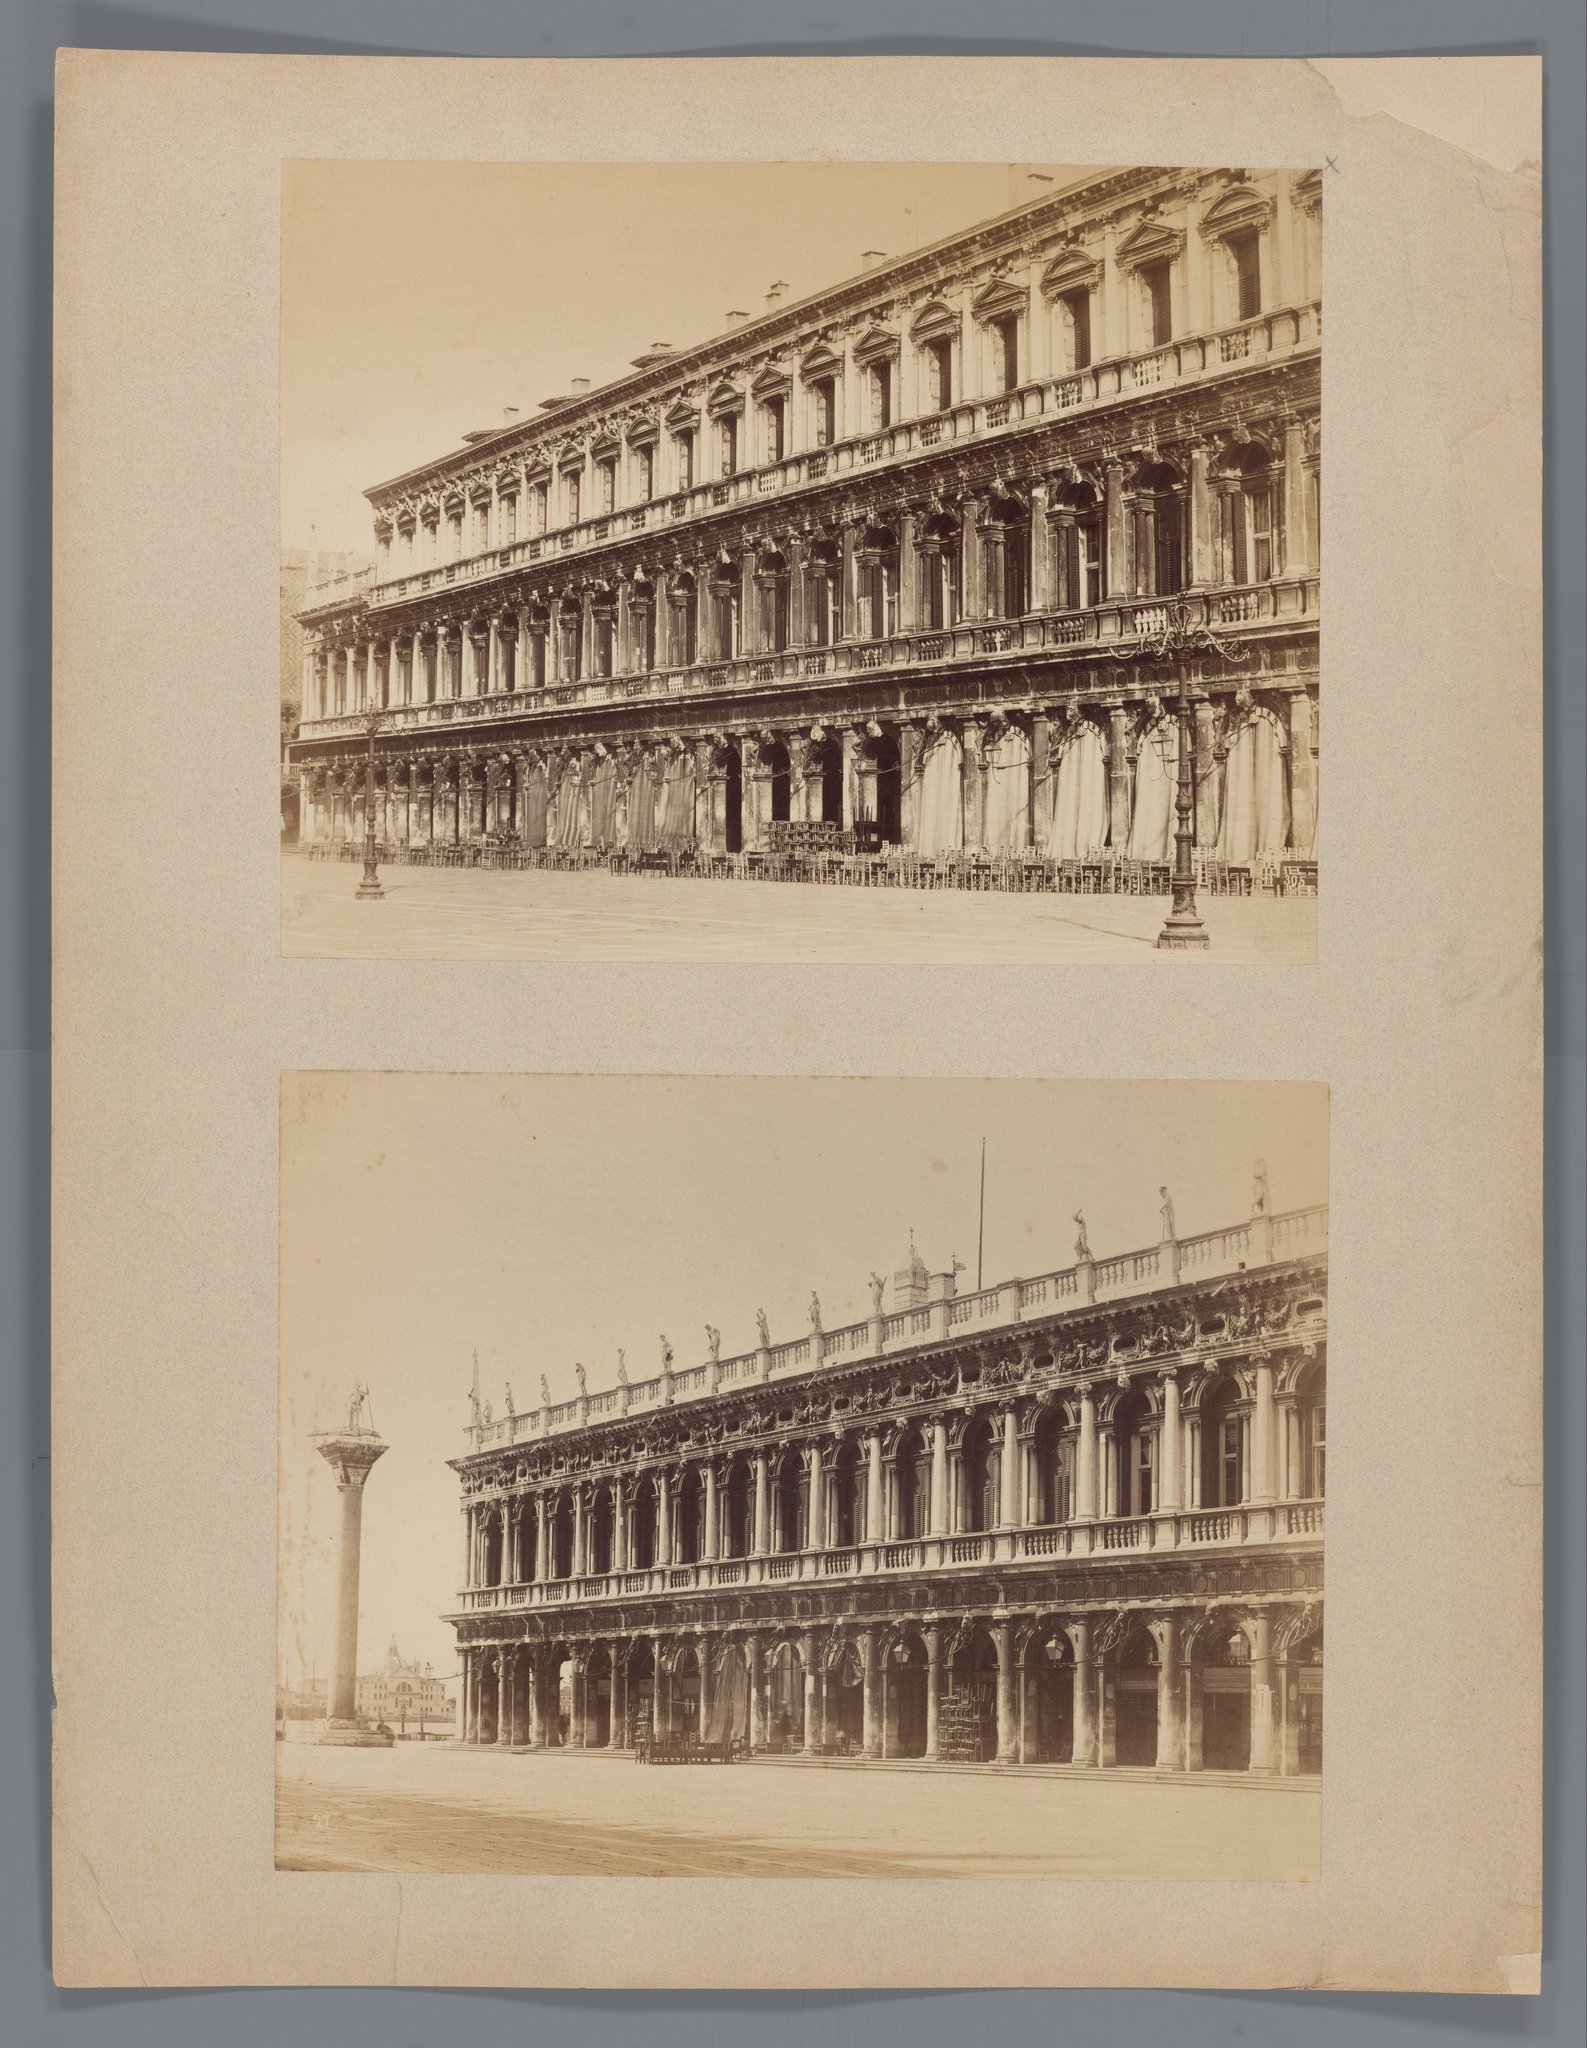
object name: photograph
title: Gezicht op een gebouw aan het Piazza San Marco te Venetië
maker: carlo naya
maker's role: fotograaf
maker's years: 1816-1882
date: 1865-1900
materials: cardboard, photographic support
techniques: albumen print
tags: san marcoplein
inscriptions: : ‘27’